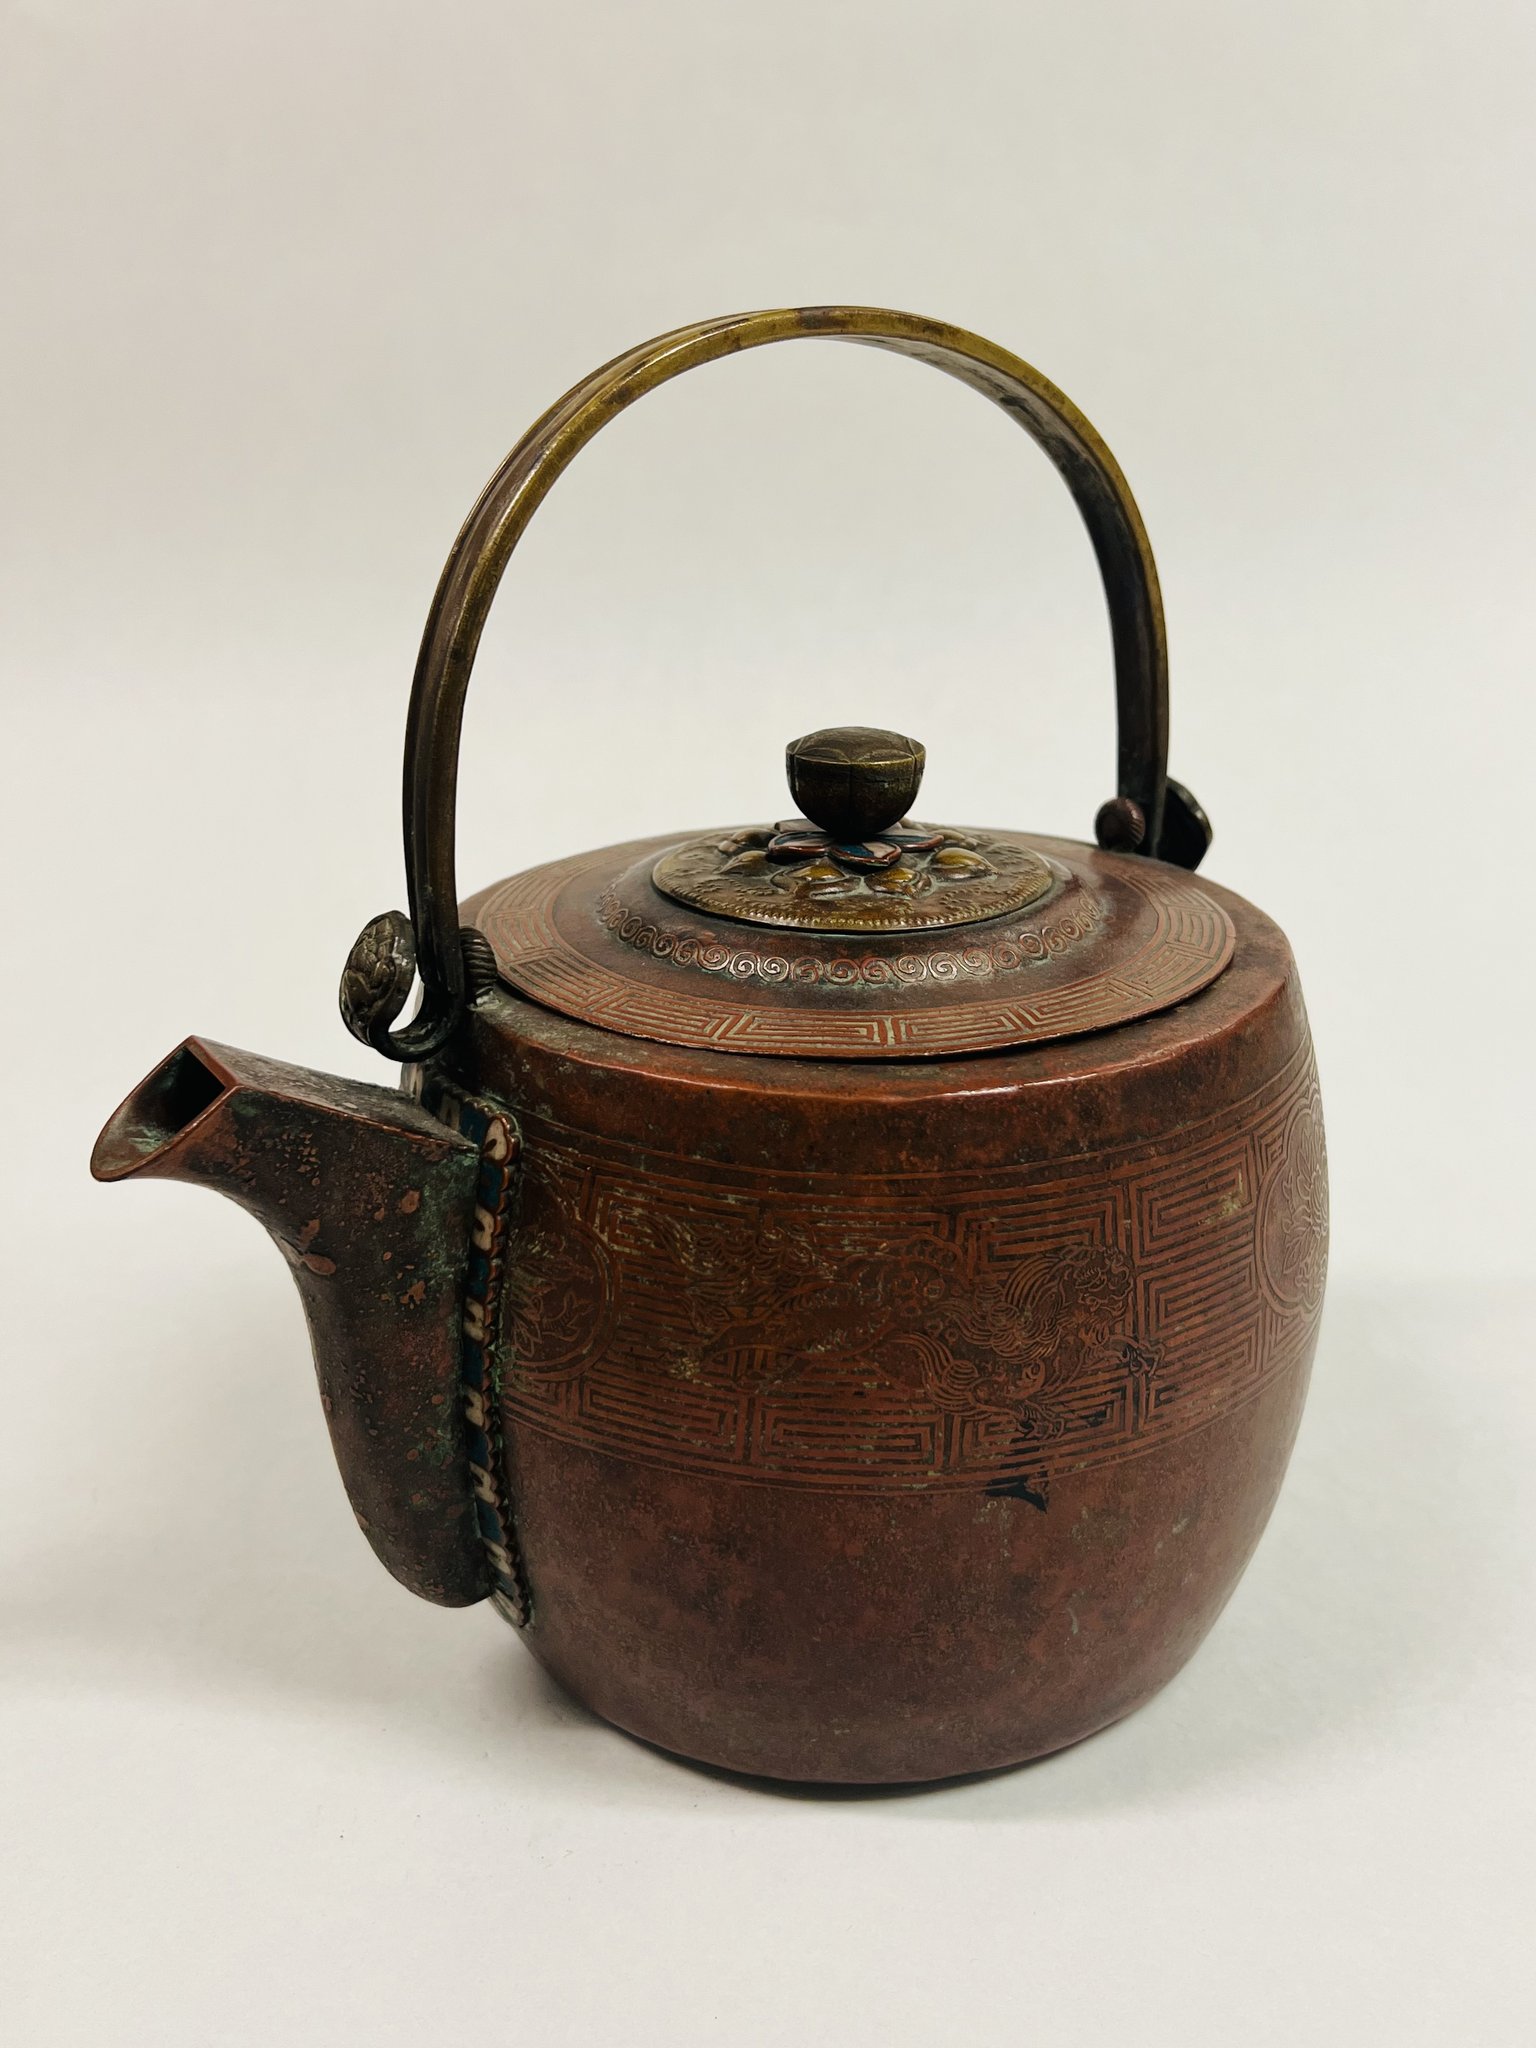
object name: pot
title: Pot for Wine or Tea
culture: japanese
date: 1801-1900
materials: bronze